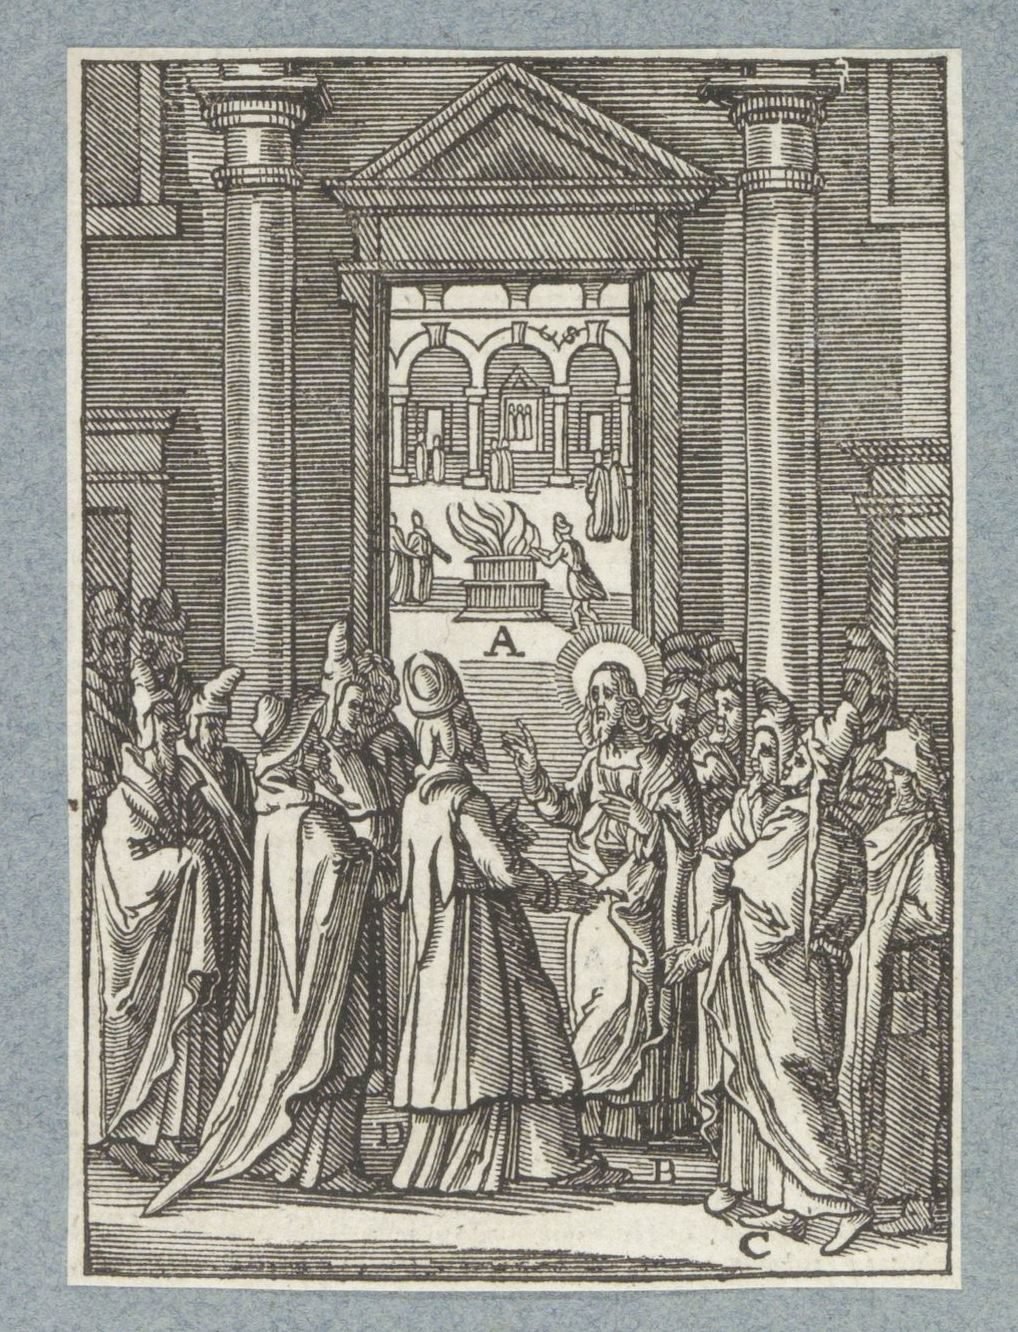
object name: print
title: Debat met de sadduceeën en de farizeeën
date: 1629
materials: paper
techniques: letterpress printing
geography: amsterdam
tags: pharisees and sadducees opposing christ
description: De prent is afkomstig uit een van de uitgaven van P.J. Paets uit Amsterdam. Ze wordt voor het eerst gebruikt in: Der Zielen Lust-hof. Leuven, I.Jacbosz voor P.J. Paets [= Amsterdam, P.J. Paets], 1629. De voorstelling is gekopieerd naar een prent van Adriaen Collaert voor: Nadal, Jerónimo. Evangelicae Historiae Imagines. Antwerpen, M. Nutius, 1593.